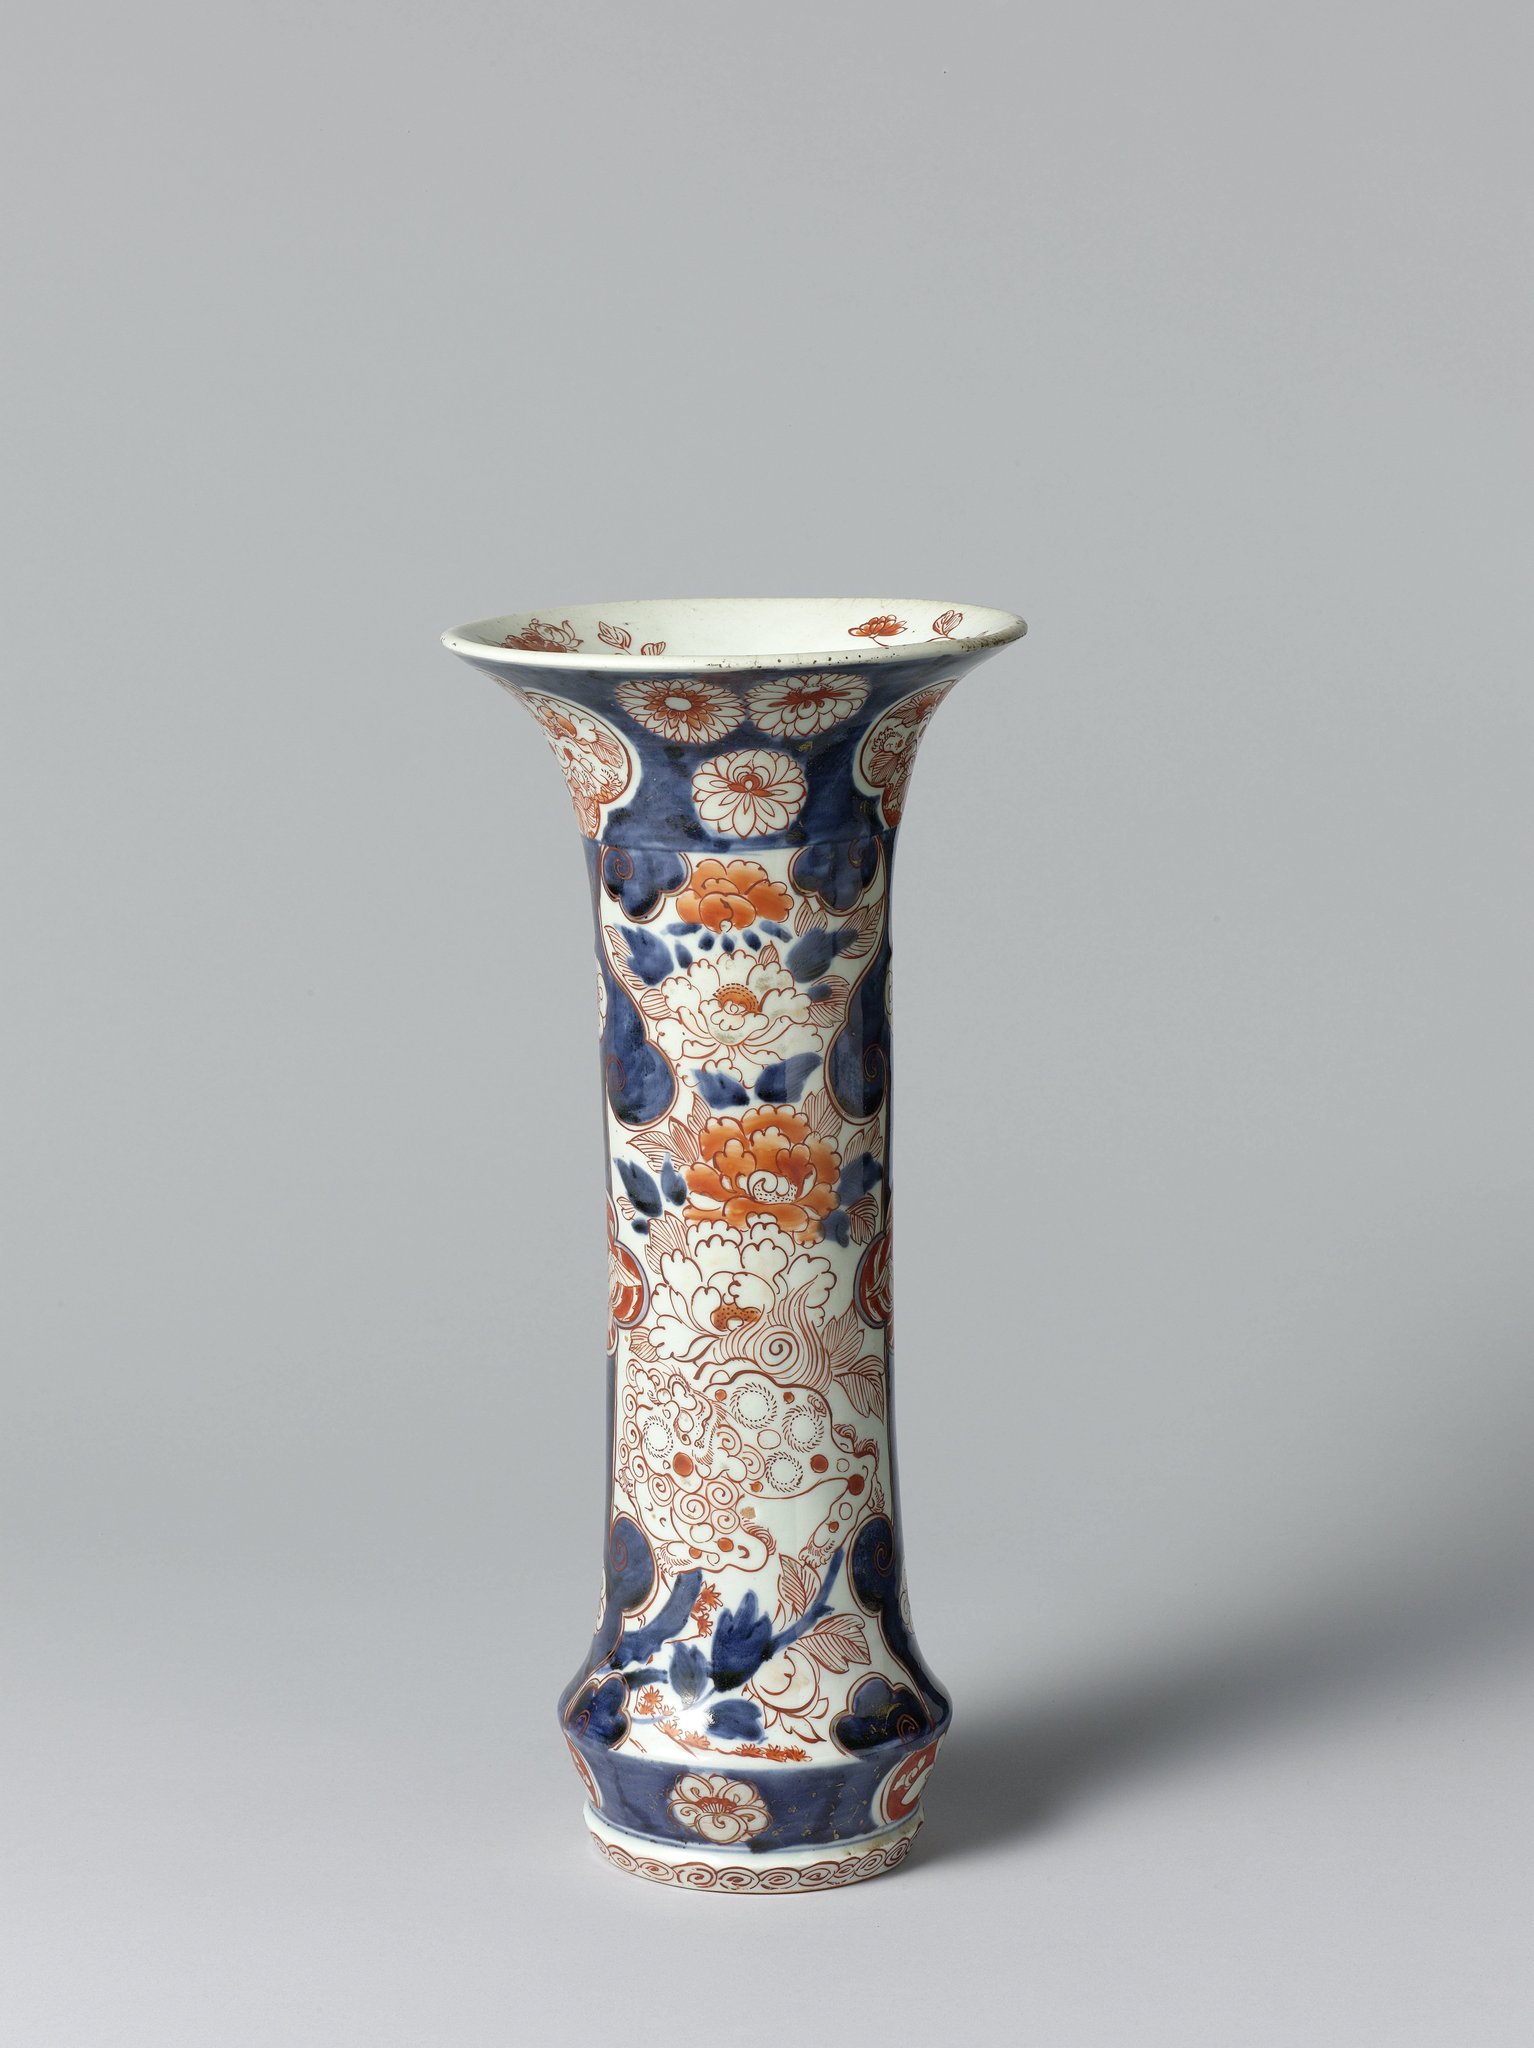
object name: vase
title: Beaker vase with shishi, hoo-birds, flowering plants and floral scrolls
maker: Anonymous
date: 1775-1824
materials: cobalt, glaze, gold, paint, porcelain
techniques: firing, forming, gilding, turning, vitrification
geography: japan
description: Bekervaas van porselein met trompetvormige mond, beschilderd in onderglazuur blauw en op het glazuur rood, zwart en goud. Op de buitenwand twee grote cartouches met een shishi (leeuwhond) tussen een bloeiende pioenplant; de cartouches zijn gescheiden door banden van krulwerk met daarin een gelobd cartouche met een hoo-vogel omgeven door bloemranken. Op de buitenrand een brede band met chrysantranken onderbroken door gelobde cartouches met een shishi tussen een plant. Rond de voet een band met lotusranken. Op de voet een band met krulwerk. De binnenzijde met een pioen- en chrysanttak. Een barst in de rand. Maakt onderdeel uit van een kaststel. Imari.